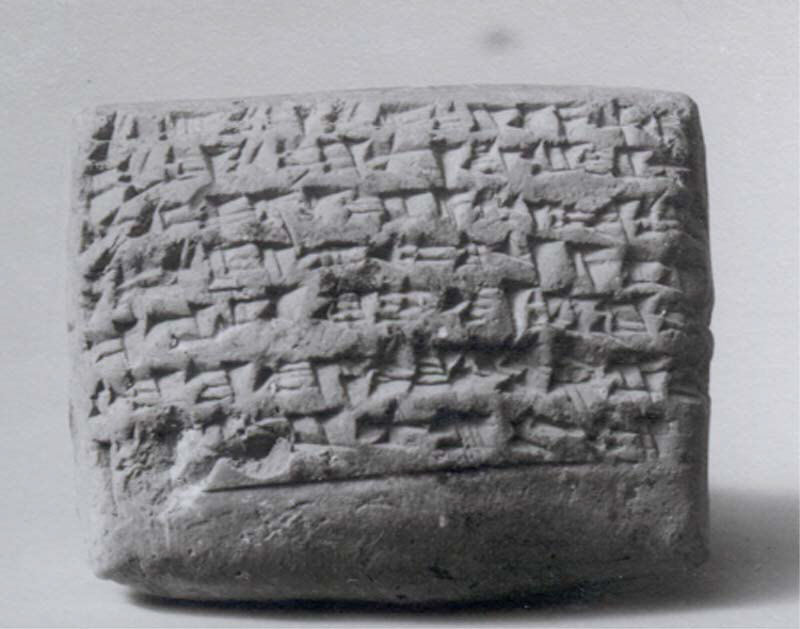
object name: cuneiform tablet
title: Cuneiform tablet: contract for workmen, Ebabbar archive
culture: babylonian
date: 591 BCE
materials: clay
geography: mesopotamia